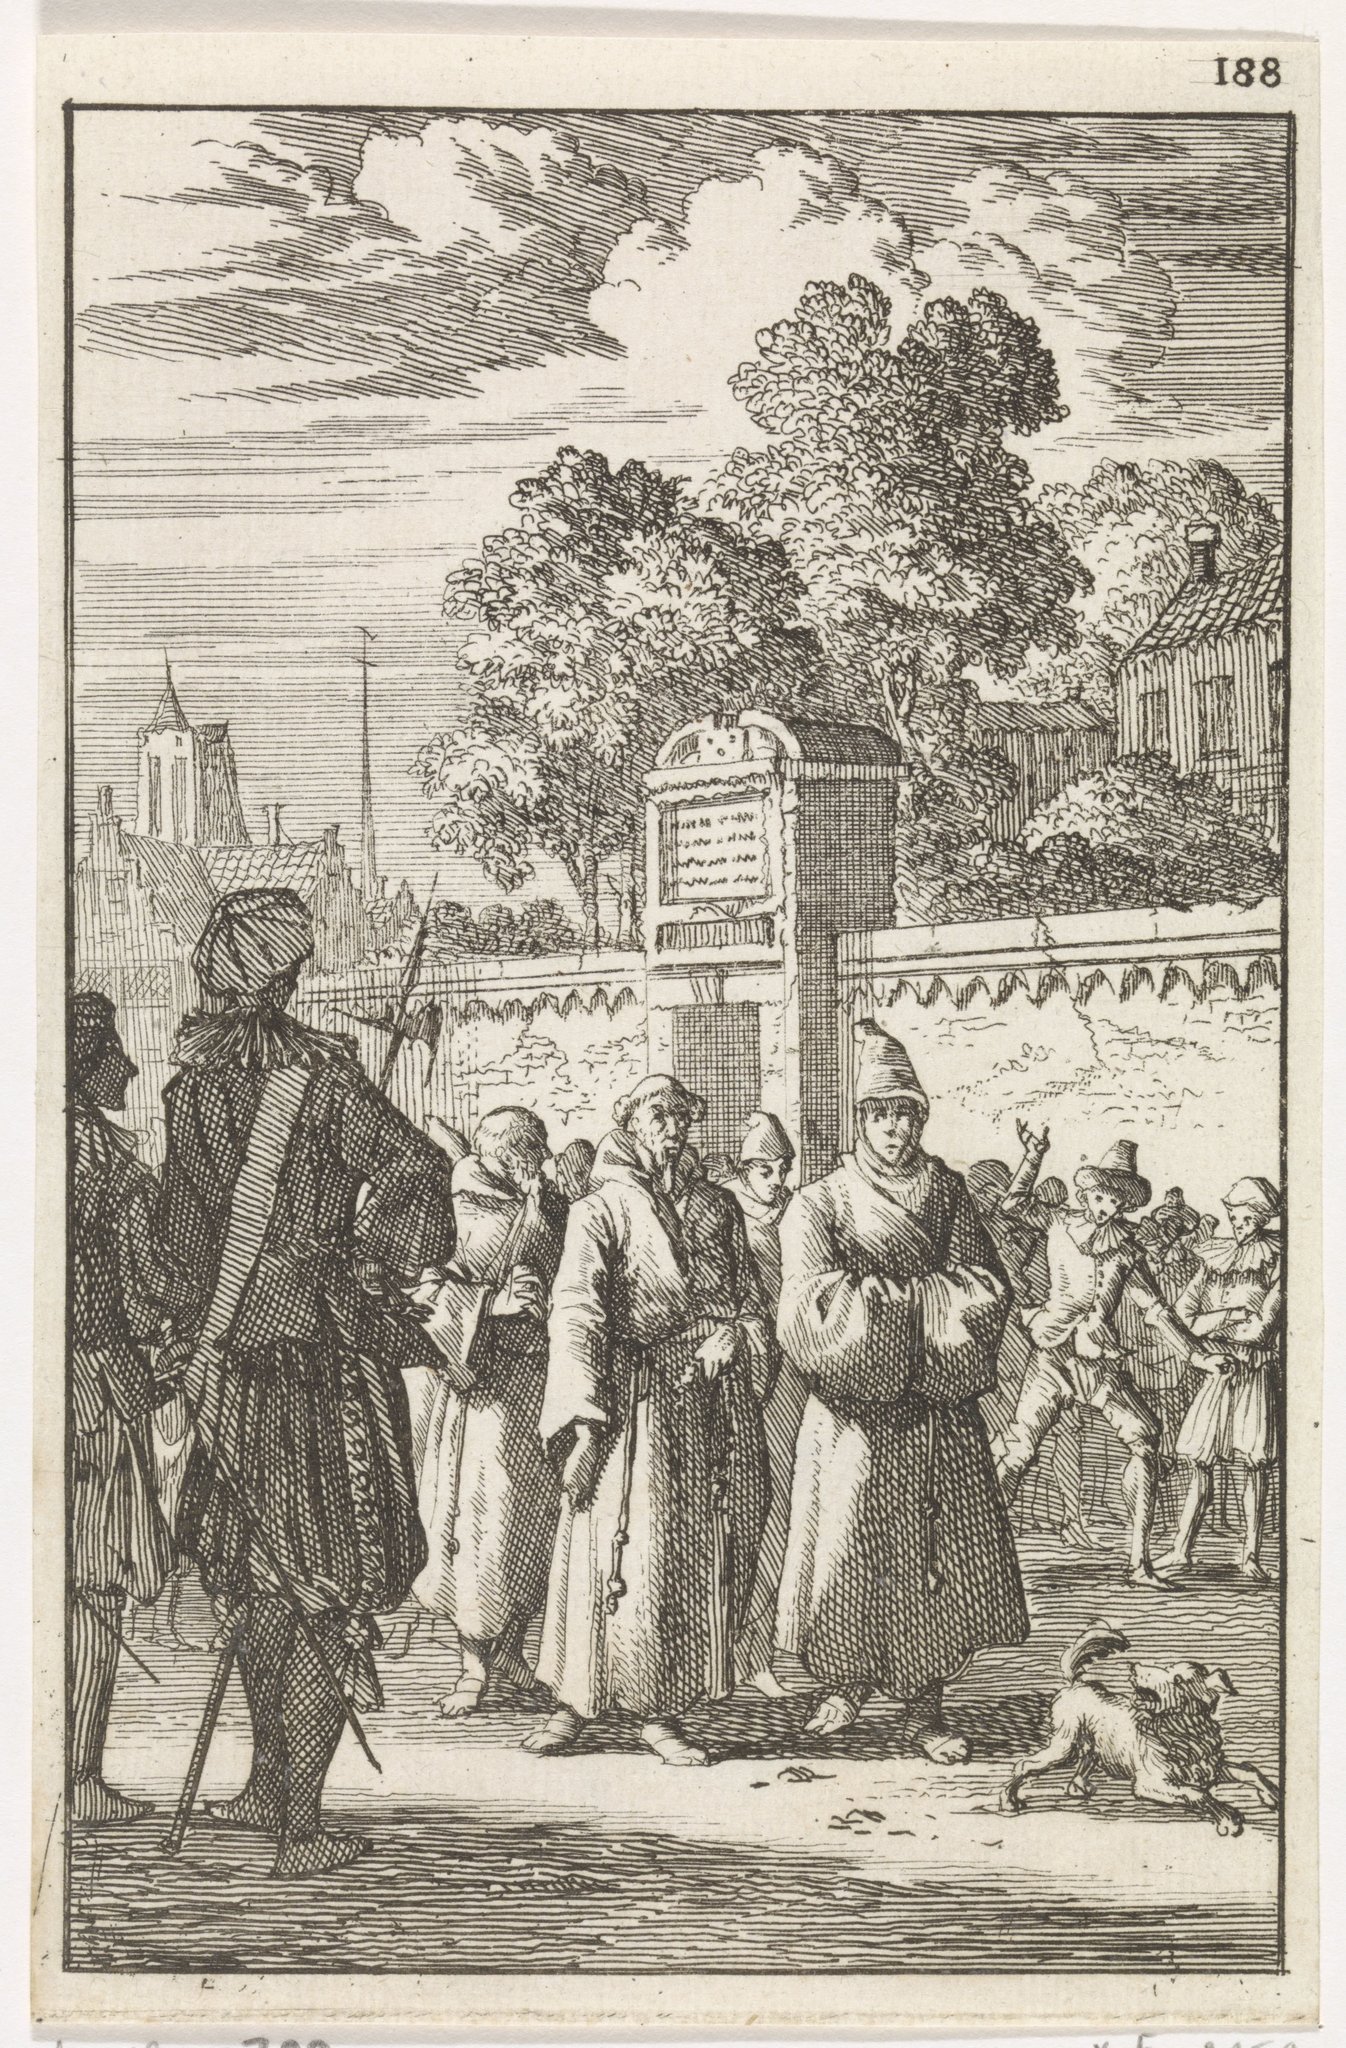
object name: history print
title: Monniken worden verbannen uit een klooster te Zierikzee, 1383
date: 1700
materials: paper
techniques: etching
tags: abbey, monastery, convent ~ roman catholic church, monk(s), friar(s)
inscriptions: collector's mark: Lugt 2228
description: Boekillustratie voor Boxhorn, Zueris van. Nederlandsche Historie, Behelsende de Staat van de Nederlandsche Kerk voor de Hervorming. Utrecht: Hermannus Ribbius, 1700, p. 188.